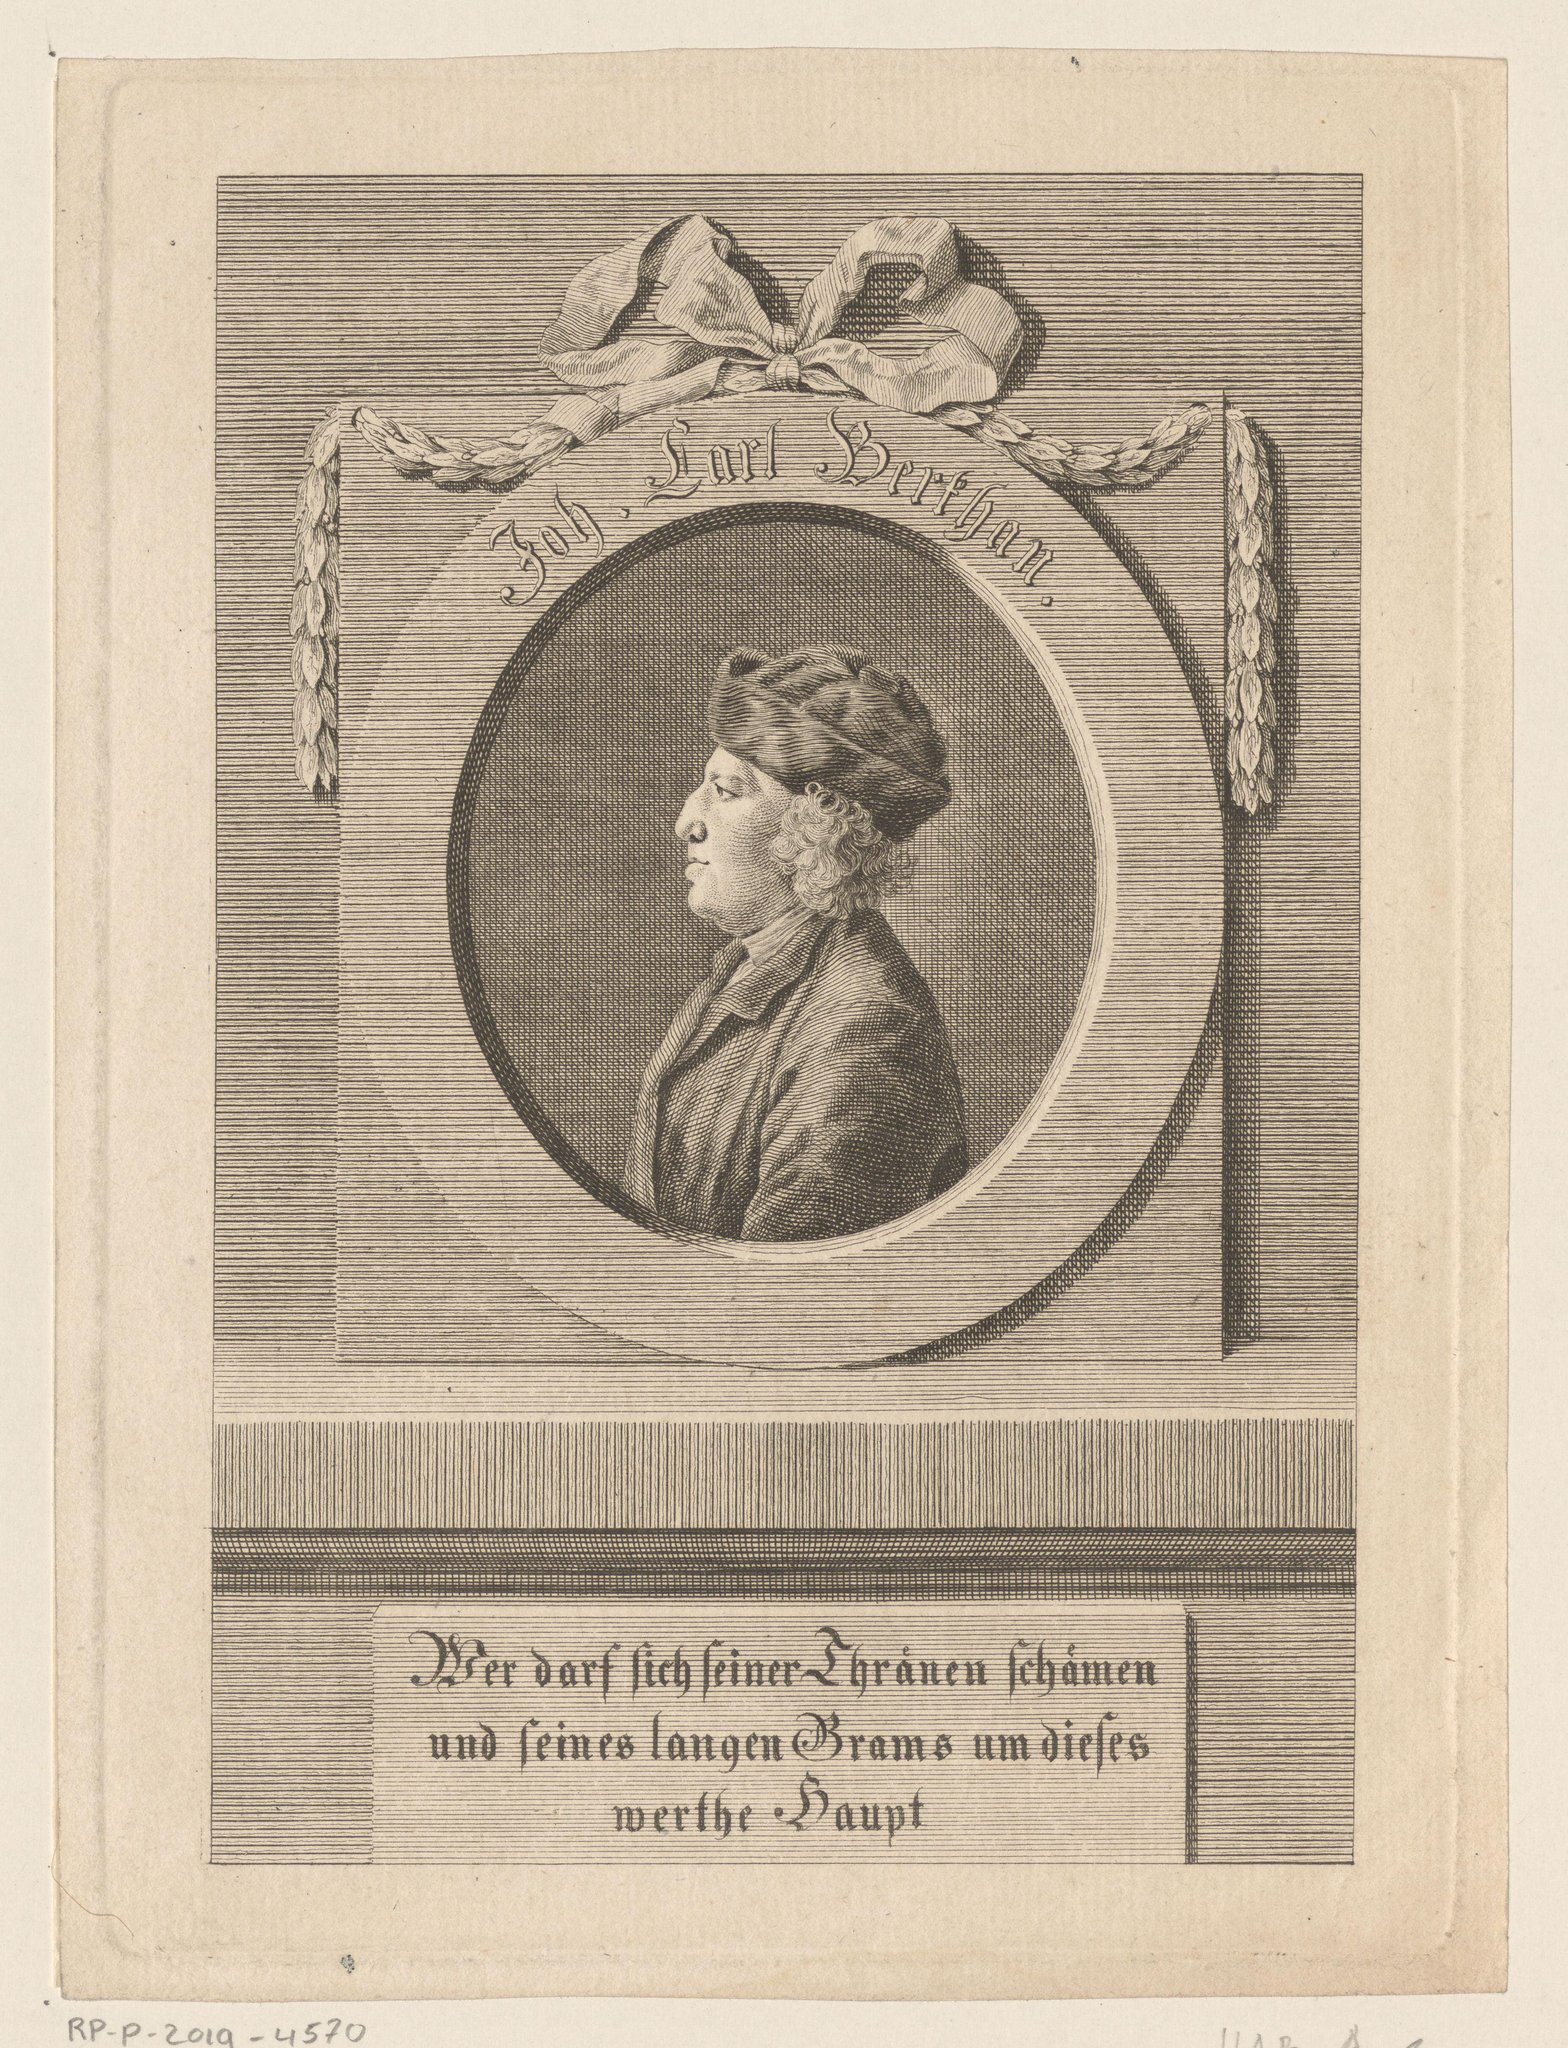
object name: print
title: Portret van Johann Carl Berthan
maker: Anonymous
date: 1700-1799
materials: paper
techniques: engraving, etching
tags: historical persons